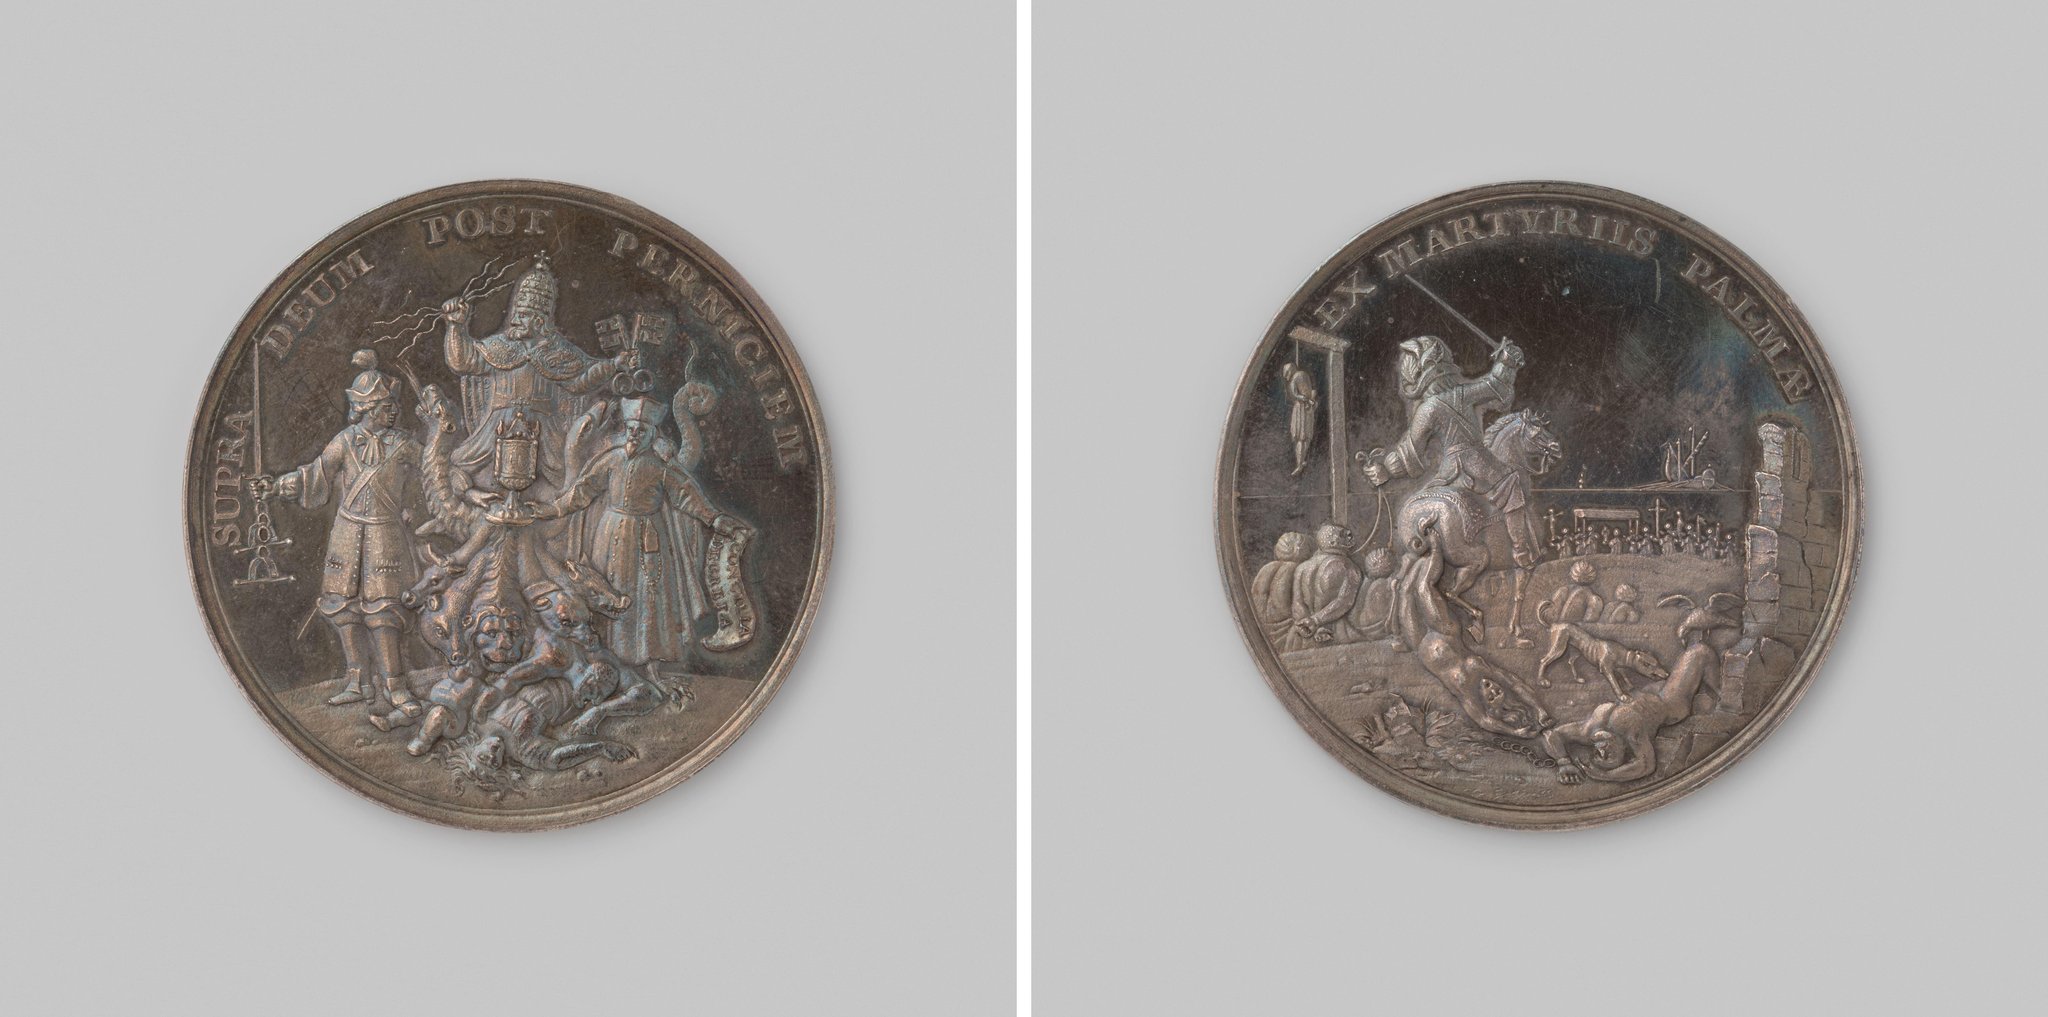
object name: history medal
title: Intrekking van het Edict van Nantes 1685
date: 1685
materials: silver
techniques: striking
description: Zilveren penning, op de voorzijde de paus met bliksem gezeten op een zevenhoofdig monster dat niet-katholieken verslindt, tussen een Frans soldaat en een Jezuiet op klauwvoeten, met omschrift, op de keerzijde het straffen van niet-katholieken.